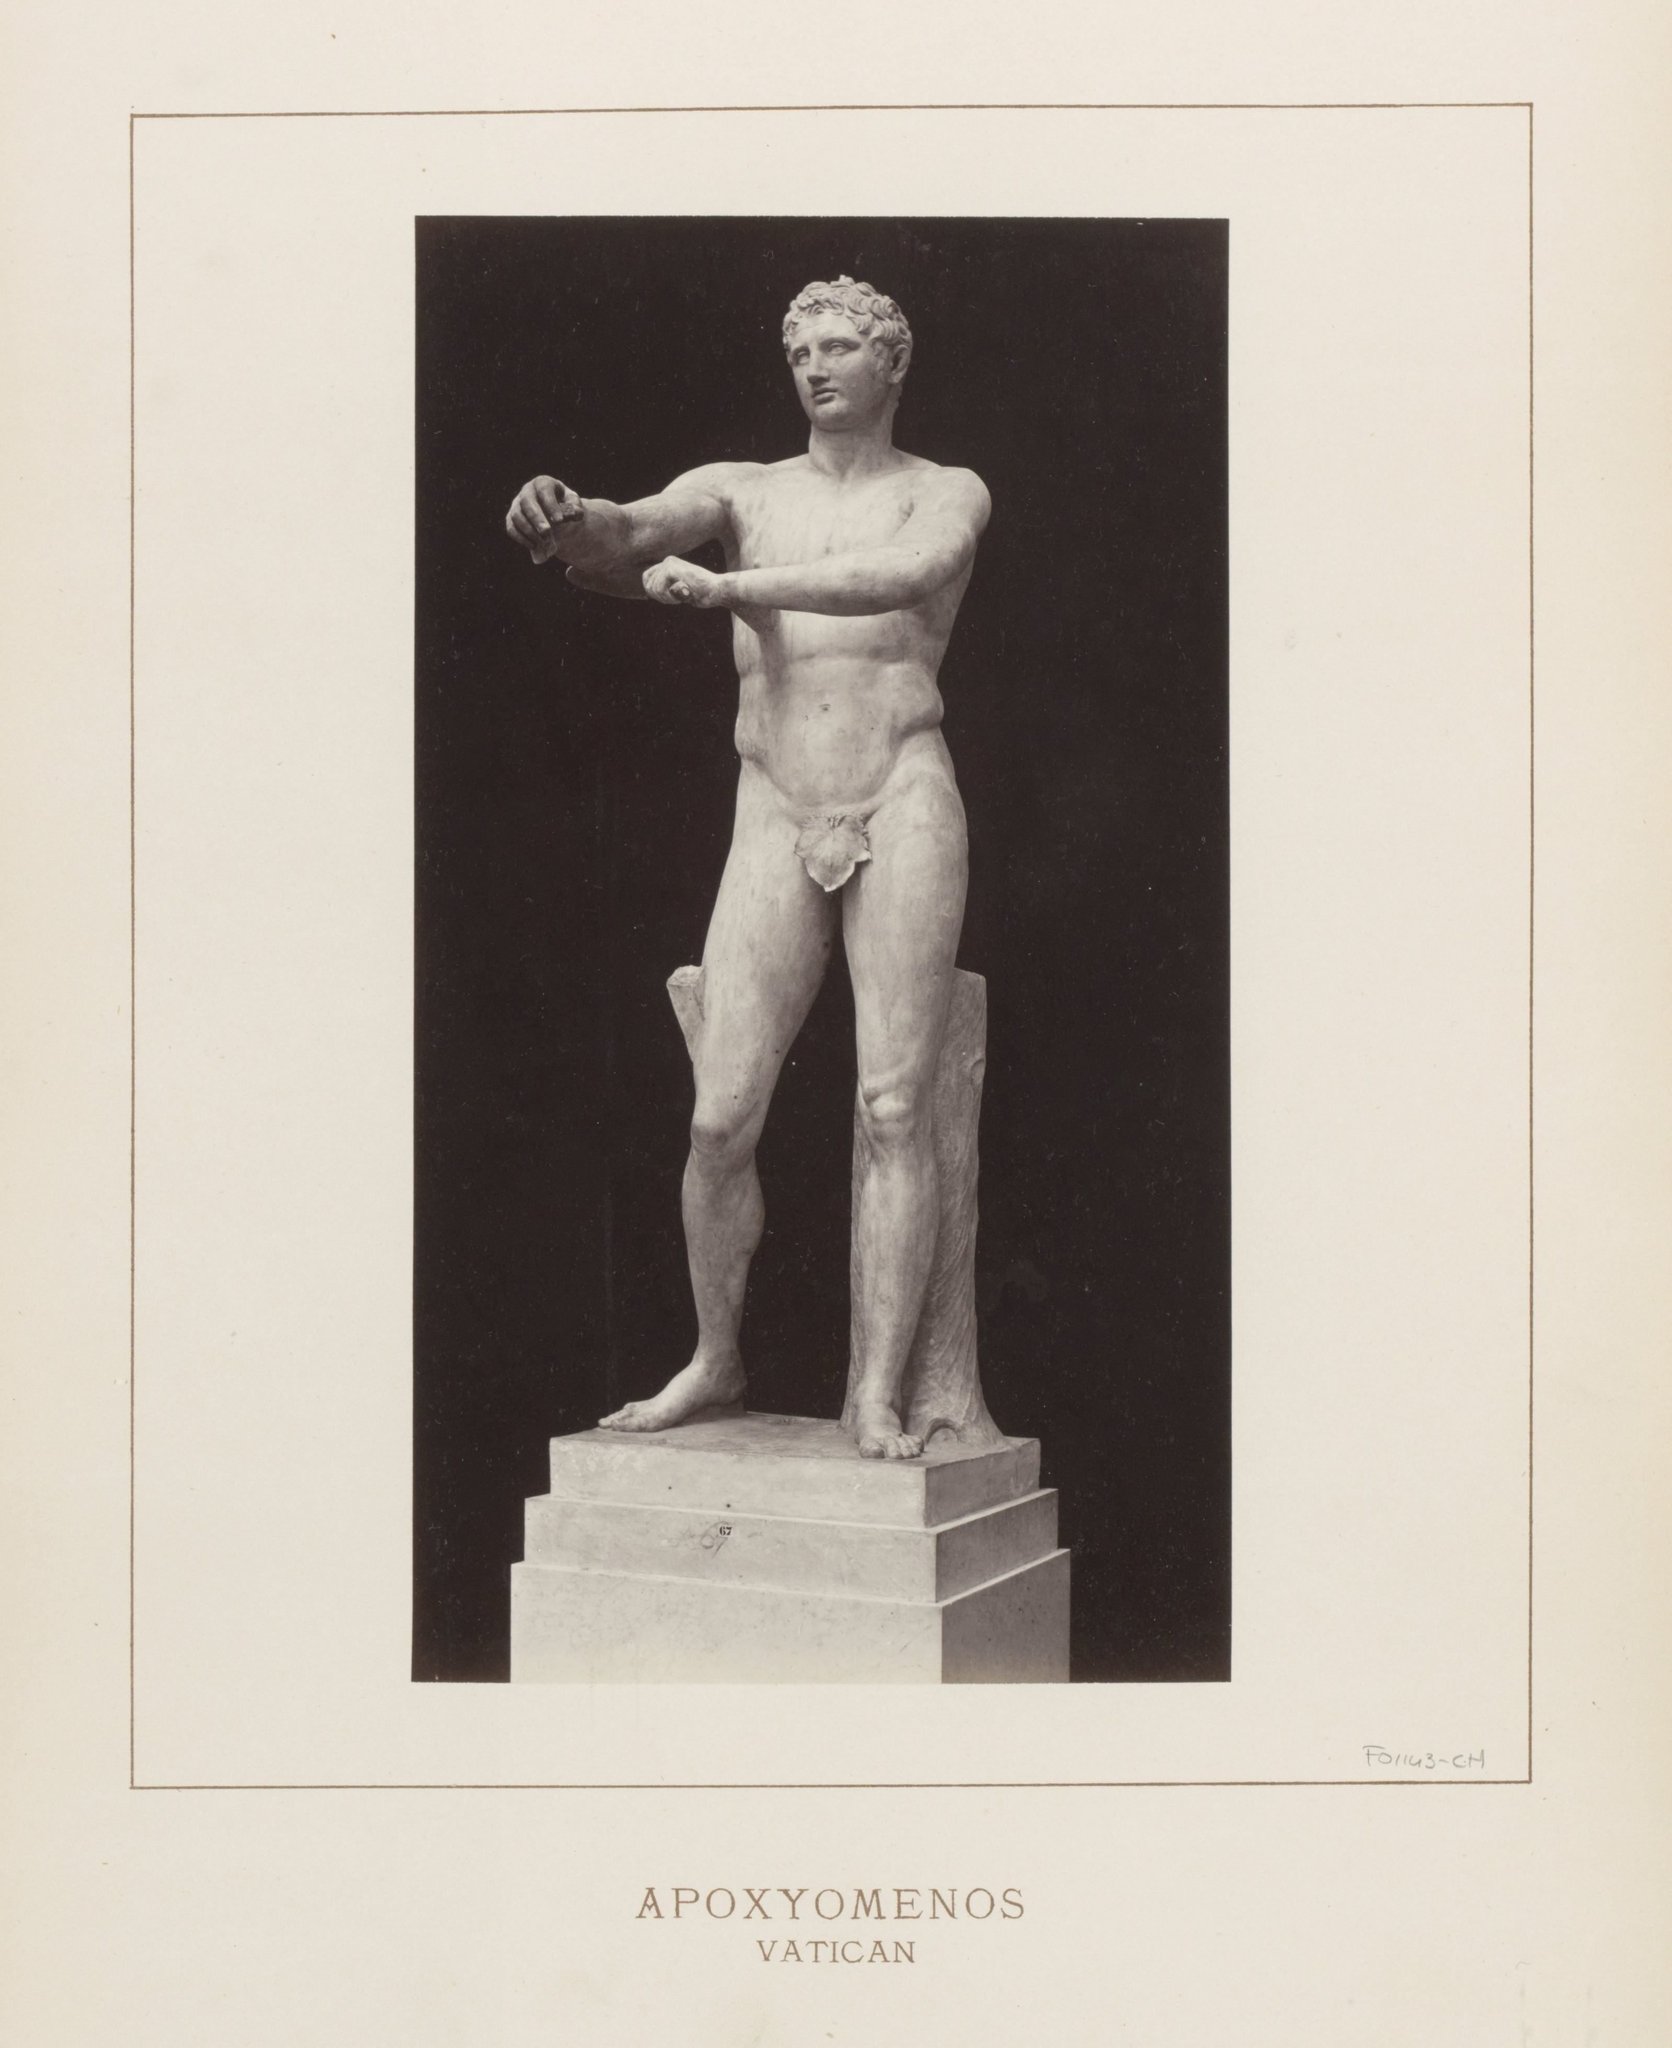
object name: photograph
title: Apoxyomenos, Vatican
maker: Anonymous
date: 1860-1900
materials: photographic support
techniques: albumen print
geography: vatican city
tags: youth, adolescent, piece of sculpture, reproduction of a piece of sculpture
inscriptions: number: ‘67’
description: Onderdeel van Fotoalbum met opnames van bezienswaardigheden en kunstwerken in Rome.